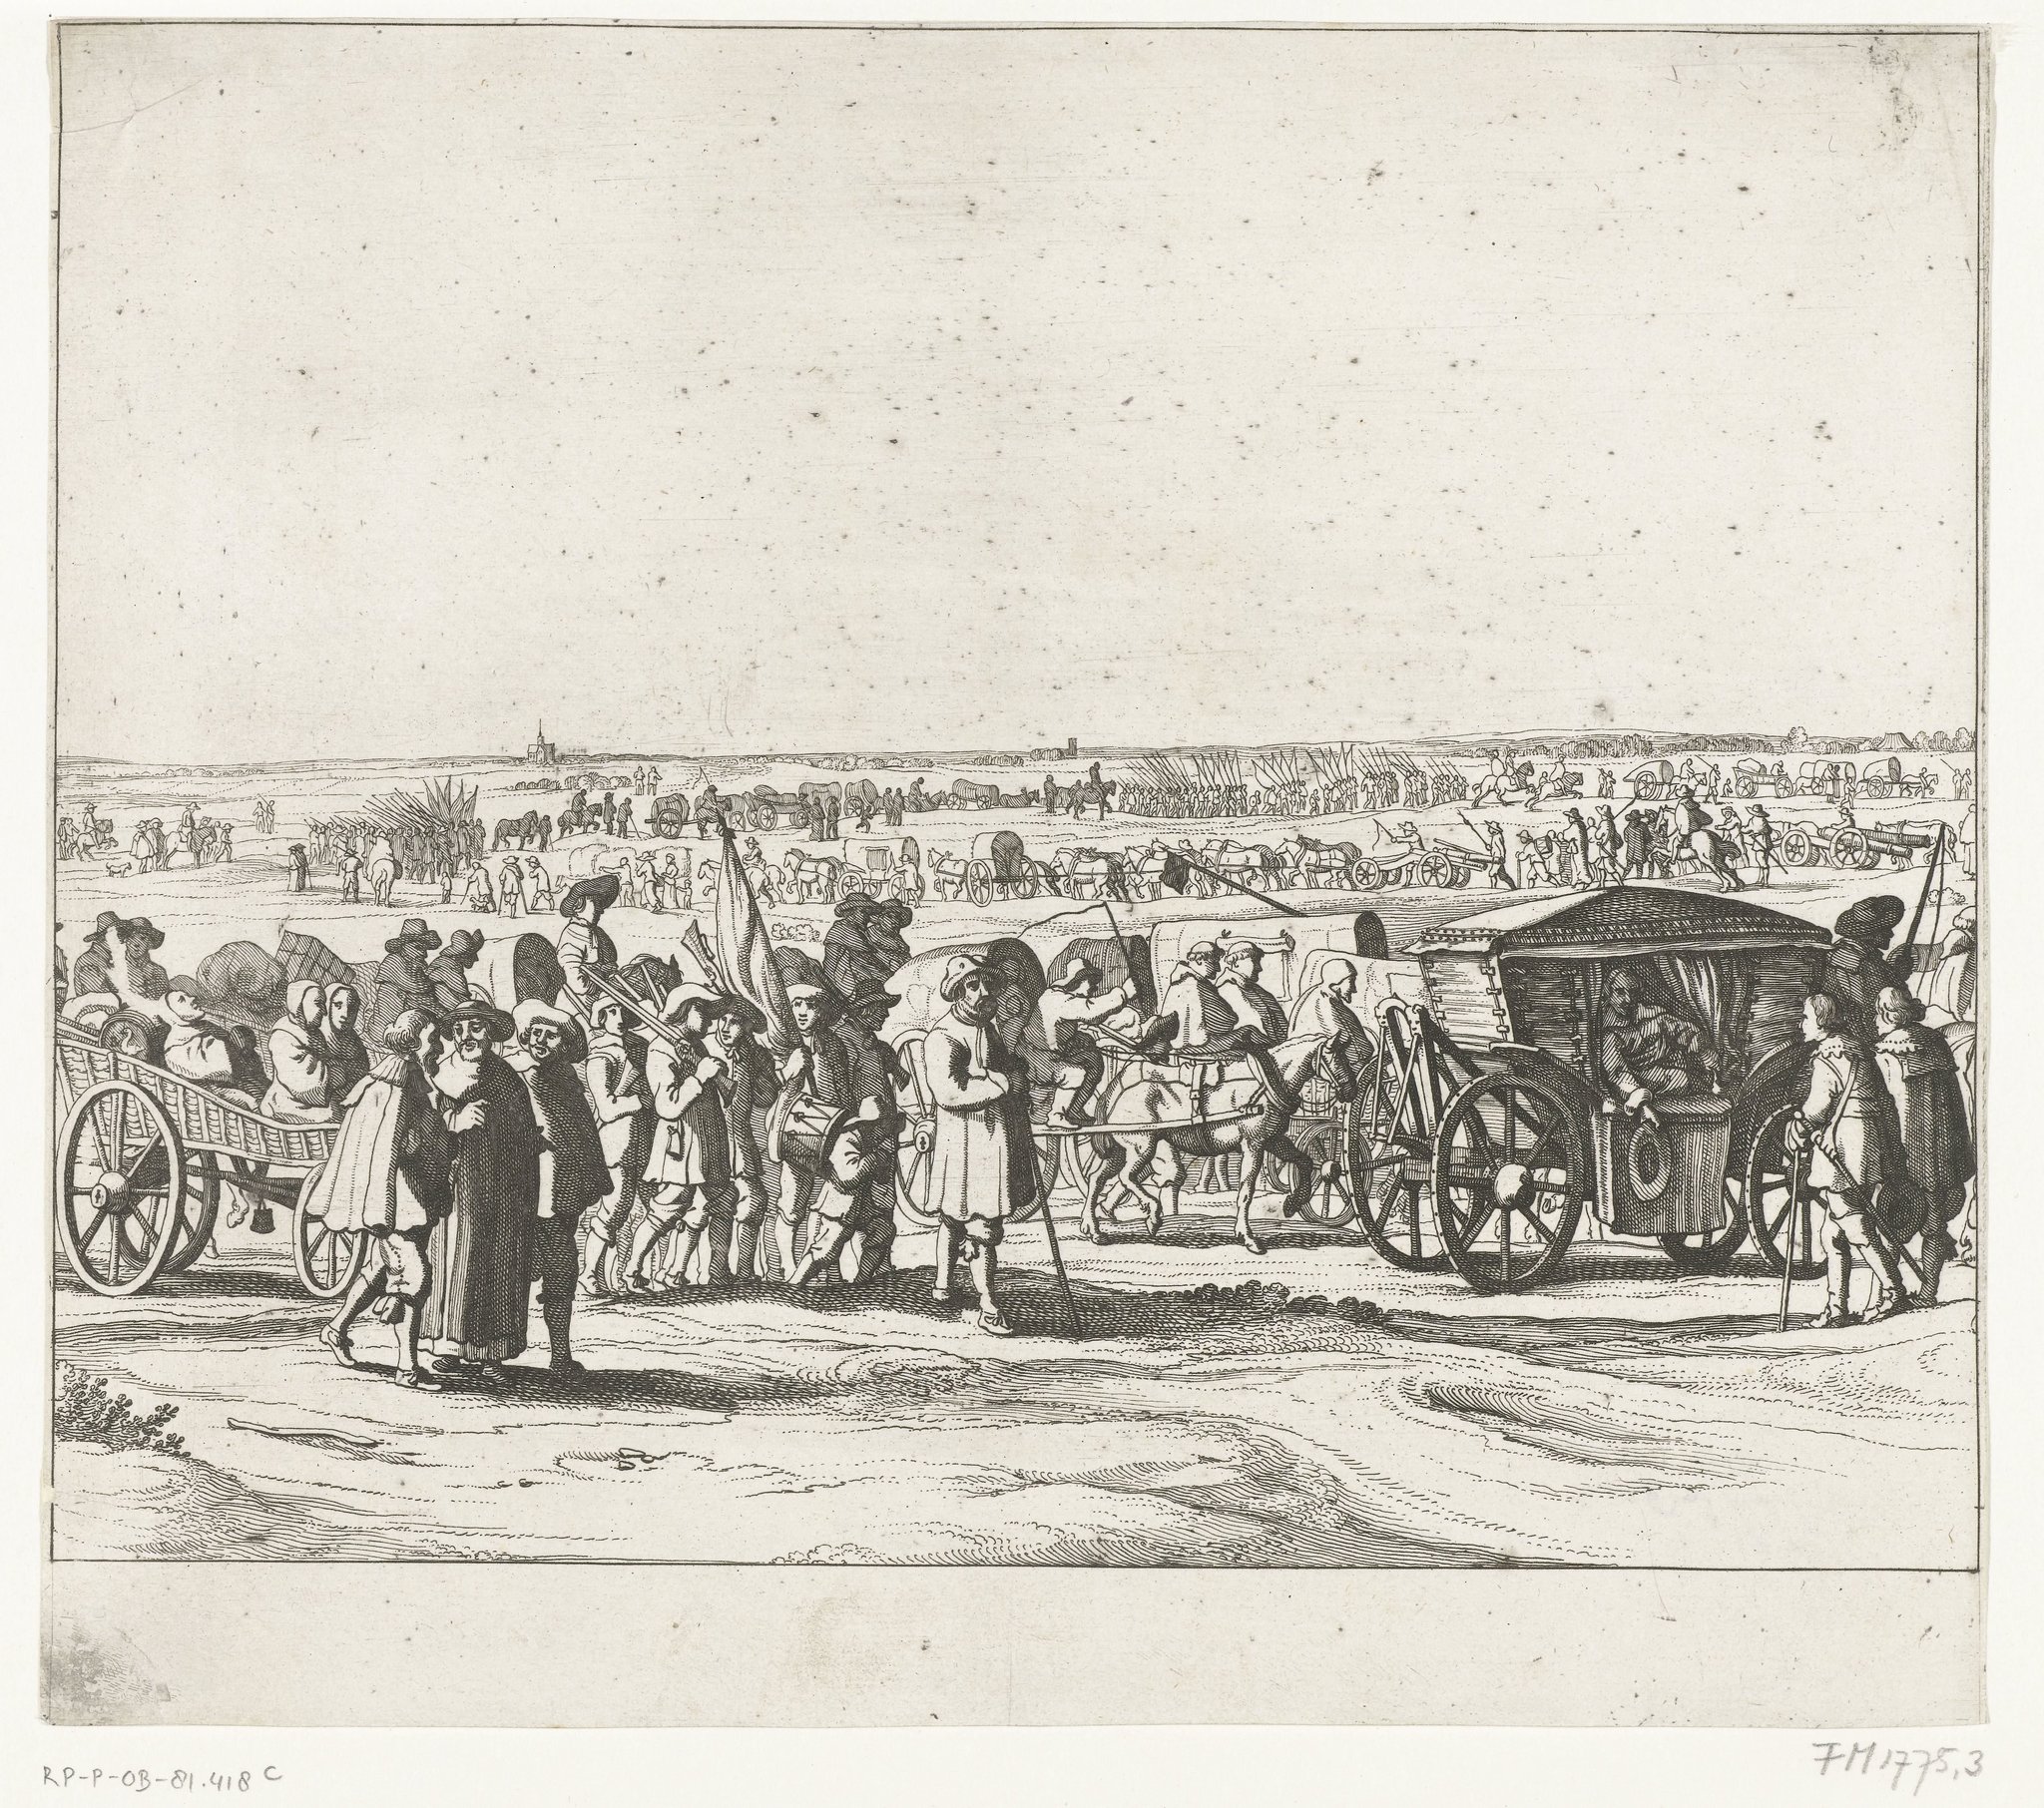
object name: print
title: Uittocht van het Spaanse garnizoen uit Breda (plaat 3), 1637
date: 1637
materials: paper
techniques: etching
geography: northern netherlands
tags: delft, the hague, frederick henry (prince of orange), retreat of the defeated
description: De uittocht van het Spaanse garnizoen uit Breda na de verovering door het Staatse leger onder Frederik Hendrik, 10 oktober 1637. Derde blad uit een ongemonteerd ensemble van vier bladen (waarvan slechts drie aanwezig). In de stoet soldaten, monniken en de gouverneur van Breda in een wagen. Op de achtergrond een deel van de stoet met kanonnen en legervoorraden.